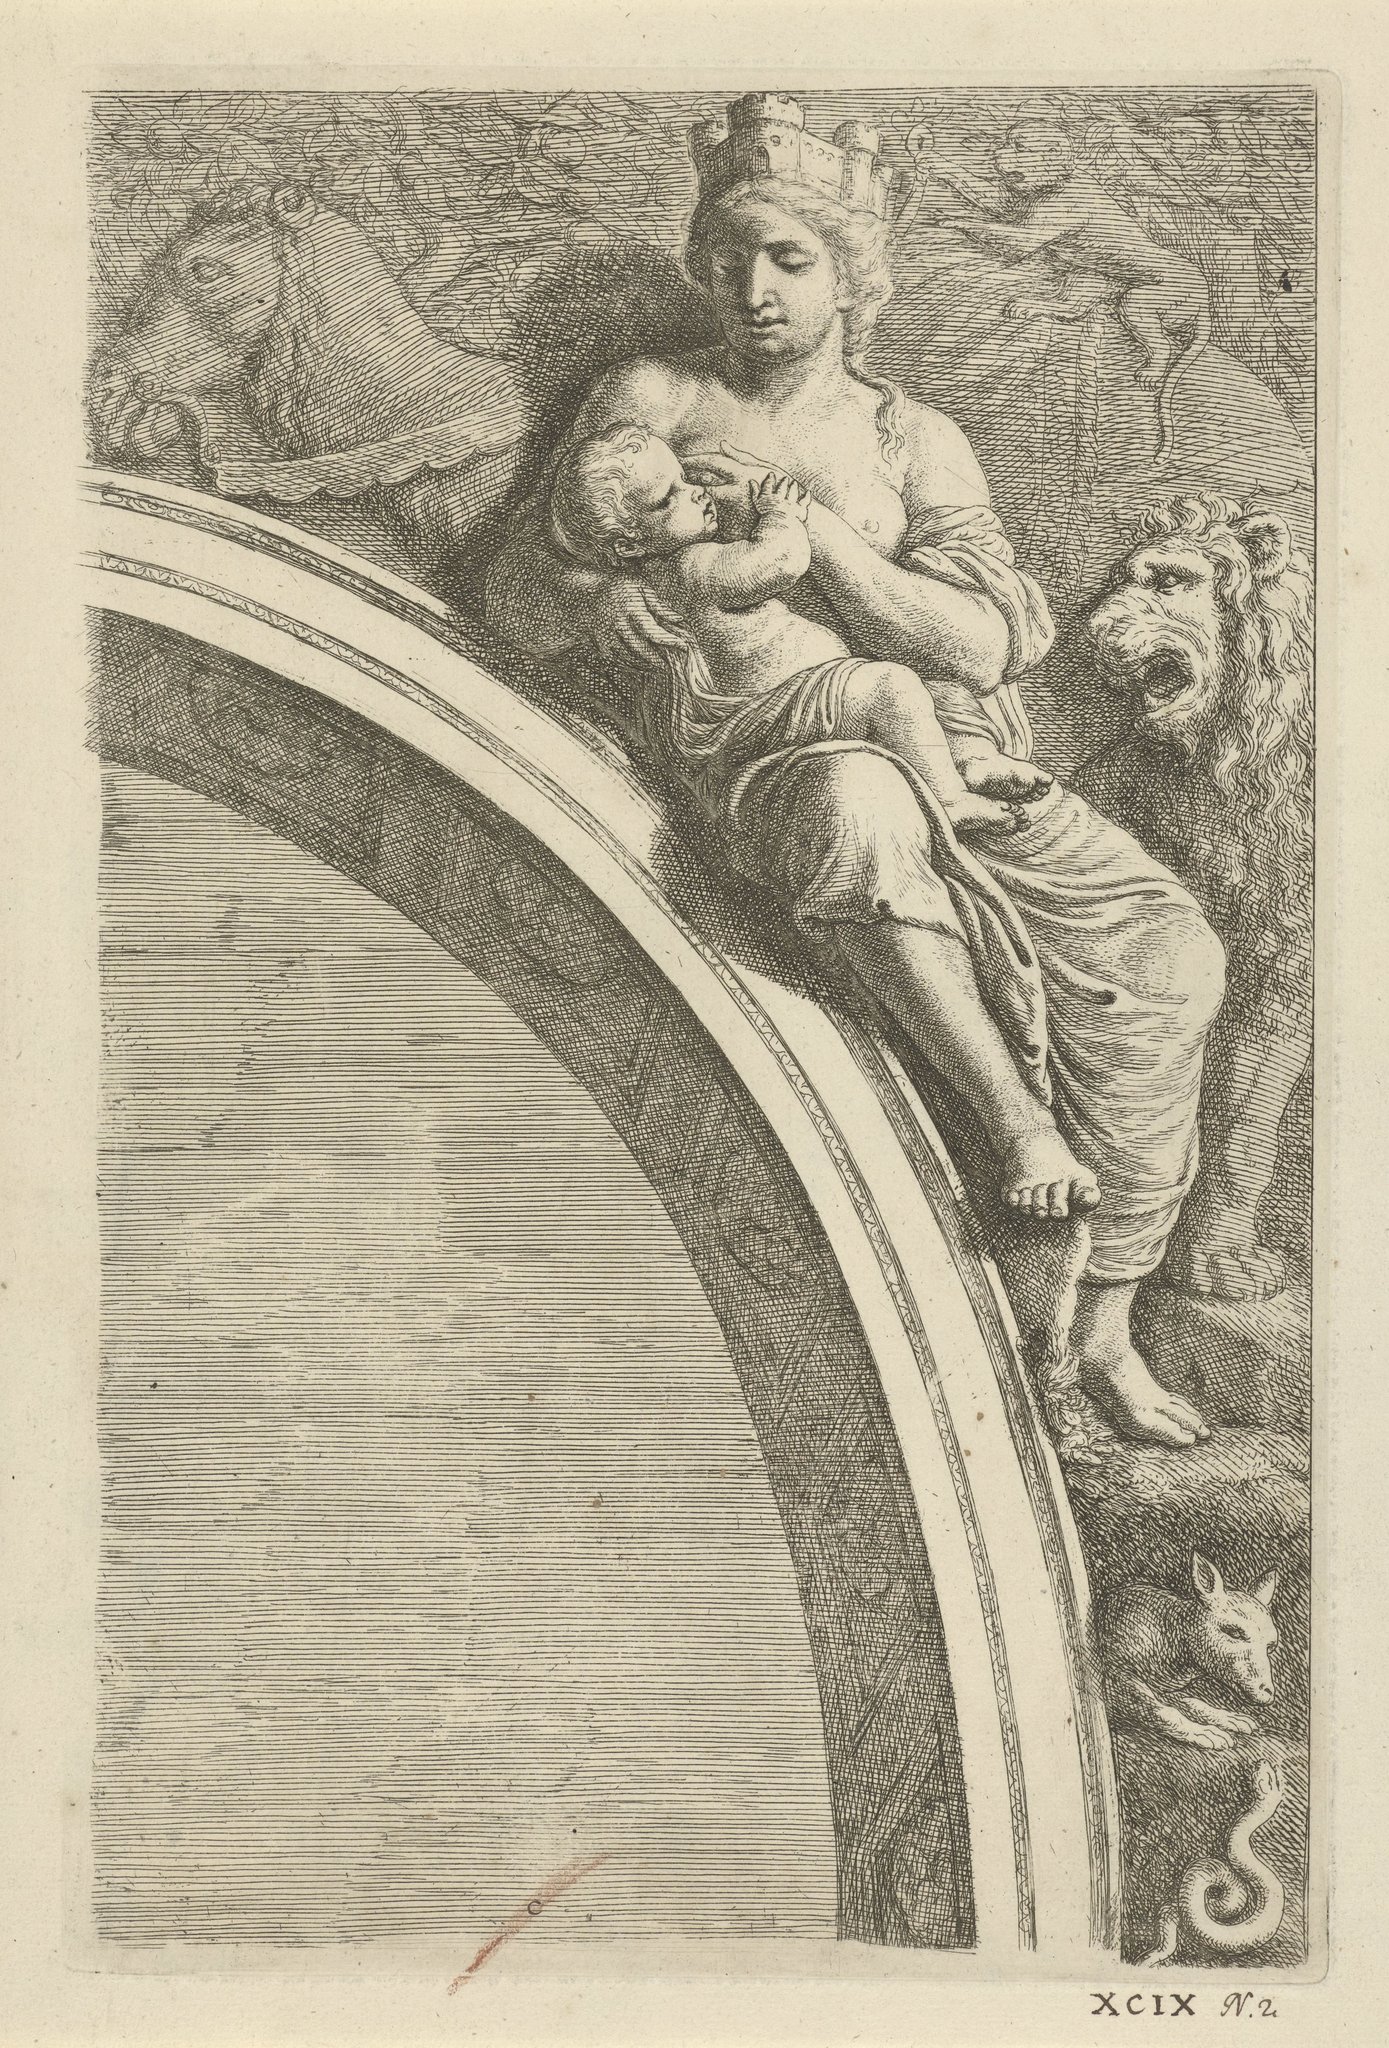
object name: book illustration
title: Reliëf met Cybele als personificatie van het element Aarde boven boog in de Burgerzaal van het Stadhuis op de Dam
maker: hubert quellinus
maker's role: print maker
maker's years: 1619-1687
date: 1663-1668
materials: chalk, ink, paper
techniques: engraving, etching, pen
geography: amsterdam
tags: hoofed animals: camel, snakes, hoofed animals: dromedary, (story of) cybele, rhea cybele, great mother of the gods (berecynt(h)ia), earth (one of the four elements), monkeys, apes, infant, baby, beasts of prey, predatory animals: lion, beasts of prey, predatory animals: fox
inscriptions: collector's mark: Lugt 2228, inscription: ‘XCIX N. 2’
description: Huidige staat van prent ook gebruikt in: Secunca pars Praecipuarum effigierum ac ornamentorum amplissime Curiae Amstelrodamensis maiori ex parte in cadido marmore effectorum per Artum Quellinium eiusdem Civitatis Statuarium / Het tweede deel Van de voornaemste Statuen ende Cieraten van 't konst-rijcke Stadt-huys van Amstelredam 'tmeeste in Marmer gemaeckt door Artus Quellinus Beelthouwer der voorseyde Stadt. Amsterdam: Artus Quellinus (I), 1663. En in: Secunca pars Praecipuarum effigierum ac ornamentorum amplissime Curiae Amstelrodamensis maiori ex parte in cadido marmore effectorum per Artum Quellinium eiusdem Civitatis Statuarium / Het tweede deel Van de voornaemste Statuen ende Cieraten van 't konst-rijcke Stadt-huys van Amstelredam 'tmeeste in Marmer gemaeckt door Artus Quellinus Beelthouwer der voorseyde Stadt. Amsterdam: Frederik de Wit, 1668. Latere staat van prent ook gebruikt in: Architecture peinture et sculpture de la Maison de Ville d'Amsterdam, representee en CIX. figures en taille-douce (…). Amsterdam: David Mortier, 1719. En in: Architecture peinture et sculpture de la Maison de Ville d'Amsterdam, representee en CIX. figures en taille-douce (…). Amsterdam: Gerard Valck, 1719. En in: Bouw schilder en beeldhouwkonst, van het Stadhuis te Amsteldam, vertoont in CIX figuuren (…). Amsterdam: Covens & Mortier & Covens Jr., s.a. (1774-1783).